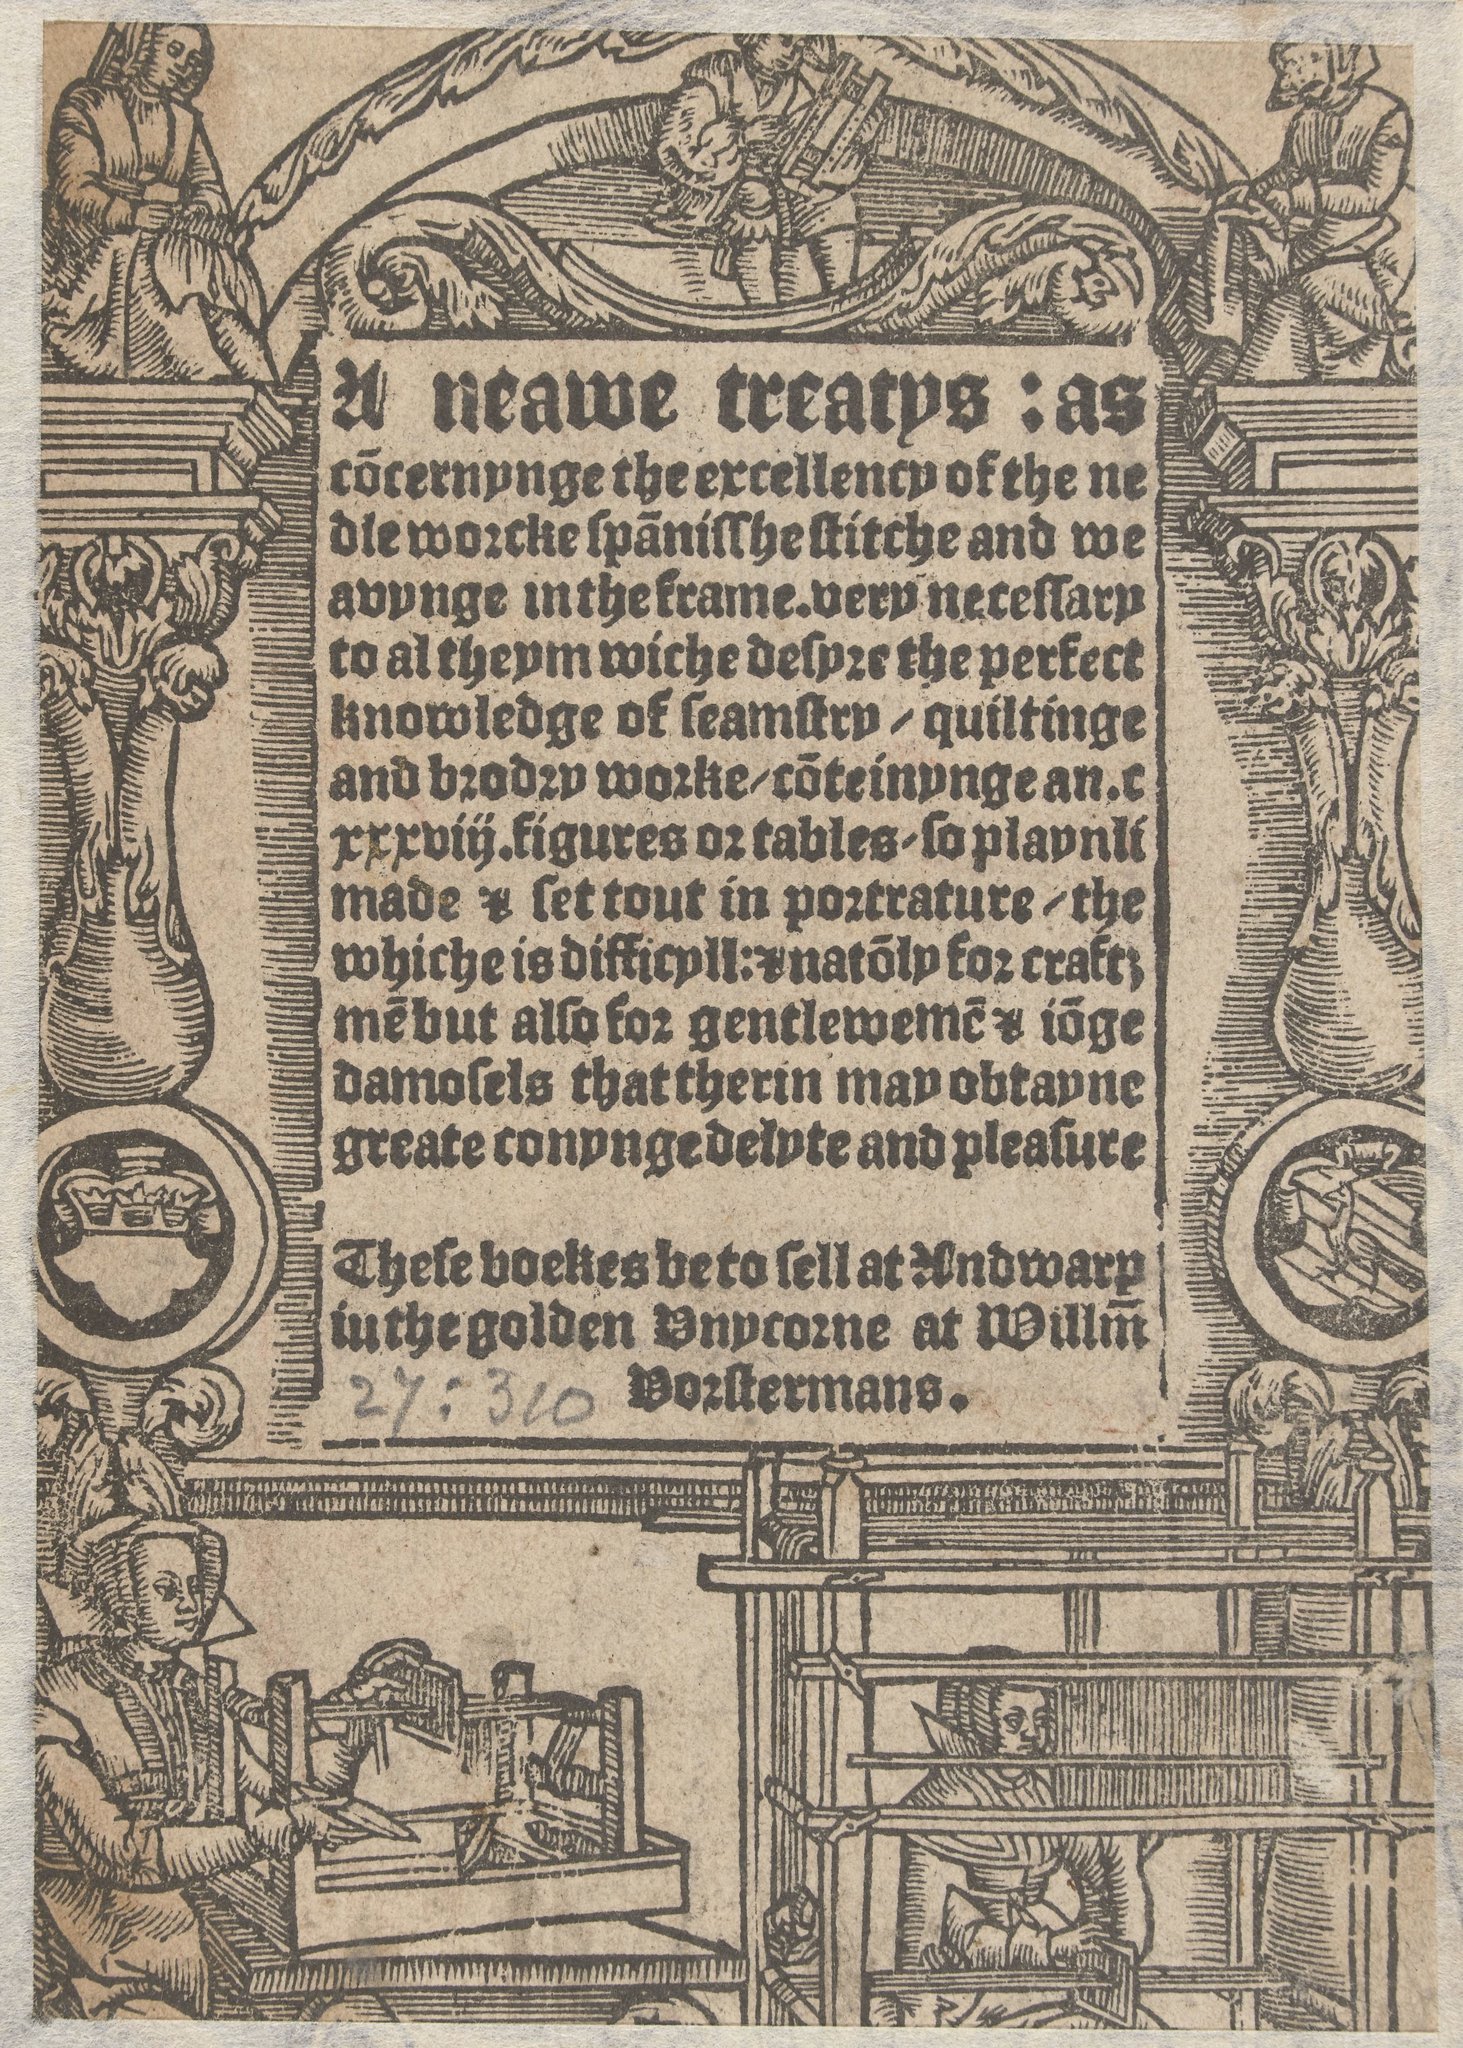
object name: book illustration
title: Titelblad van traktaat over de naaikunst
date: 1520-1540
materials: paper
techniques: woodcut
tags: (other forms of) needlework, e.g.: crocheting, knitting, embroidering, weaving, sewing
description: Illustratie op folio 1a van "Tractat de la noble art de leguille", uitgegeven door Willem Vorsterman te Antwerpen, ca. 1530. Deze houtsnede komt uit de Engelse editie.